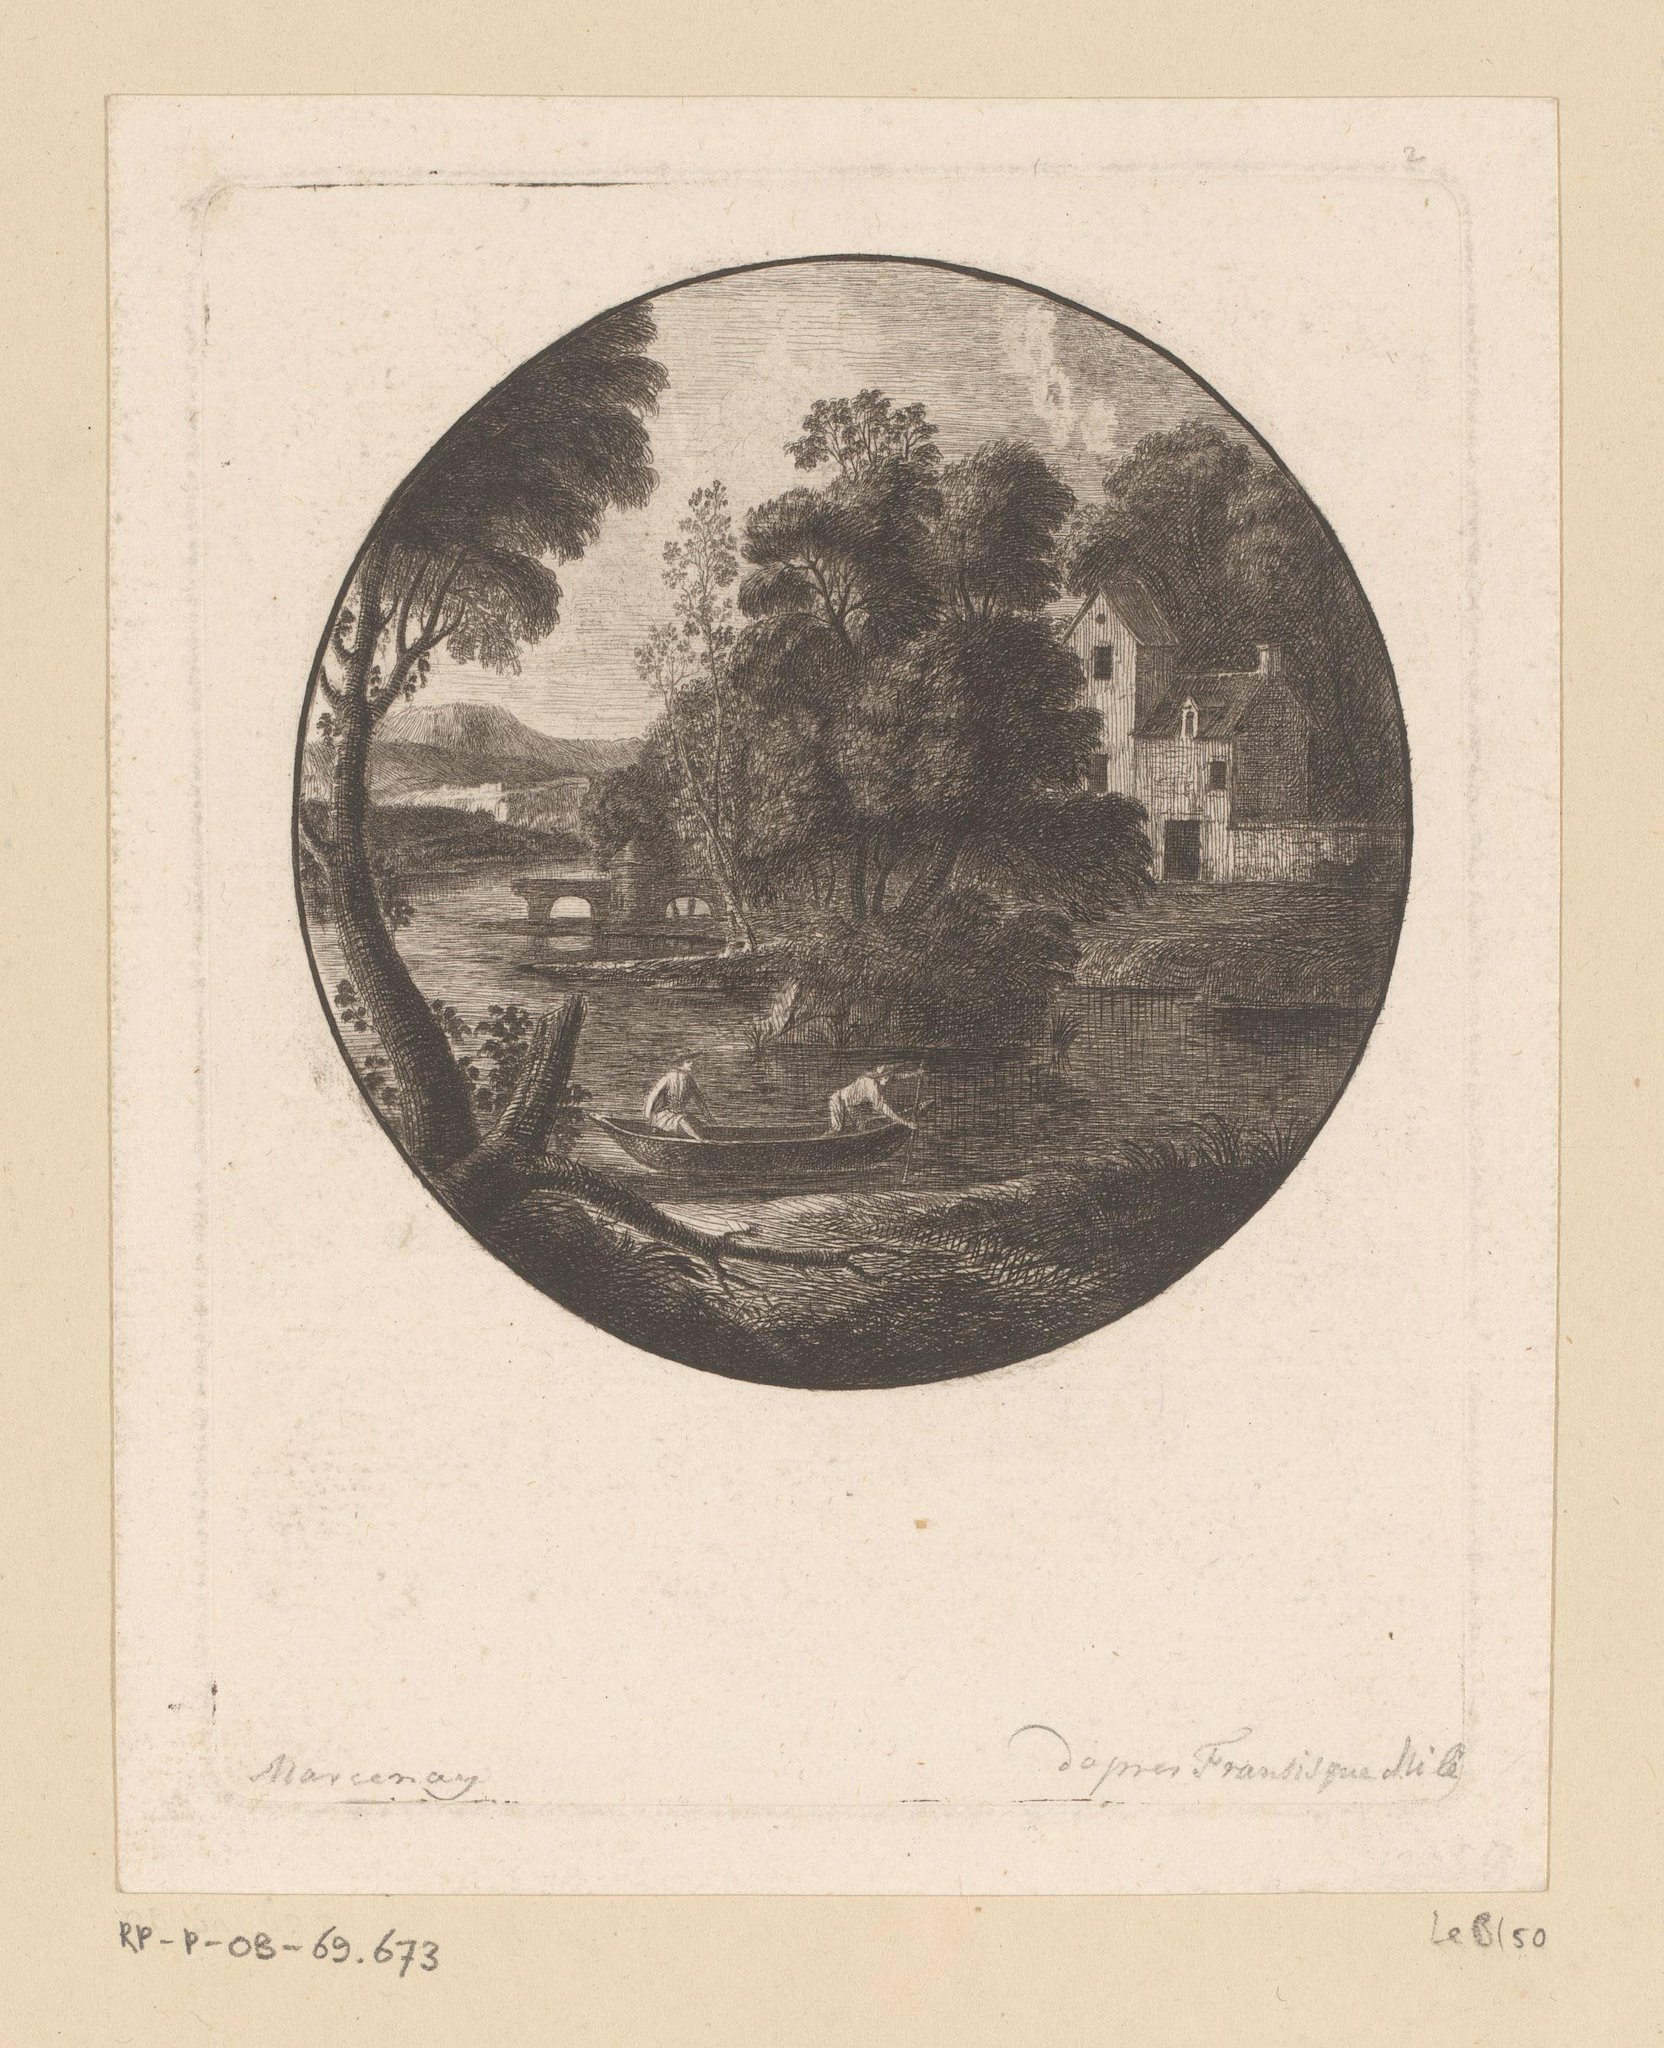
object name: print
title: Rivierlandschap met twee mannen in een boot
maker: antoine de marcenay de ghuy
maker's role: print maker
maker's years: 1724-1811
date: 1734-1811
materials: paper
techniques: engraving, etching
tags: river, rowing-boat, canoe, etc.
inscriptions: collector's mark: Lugt 2228